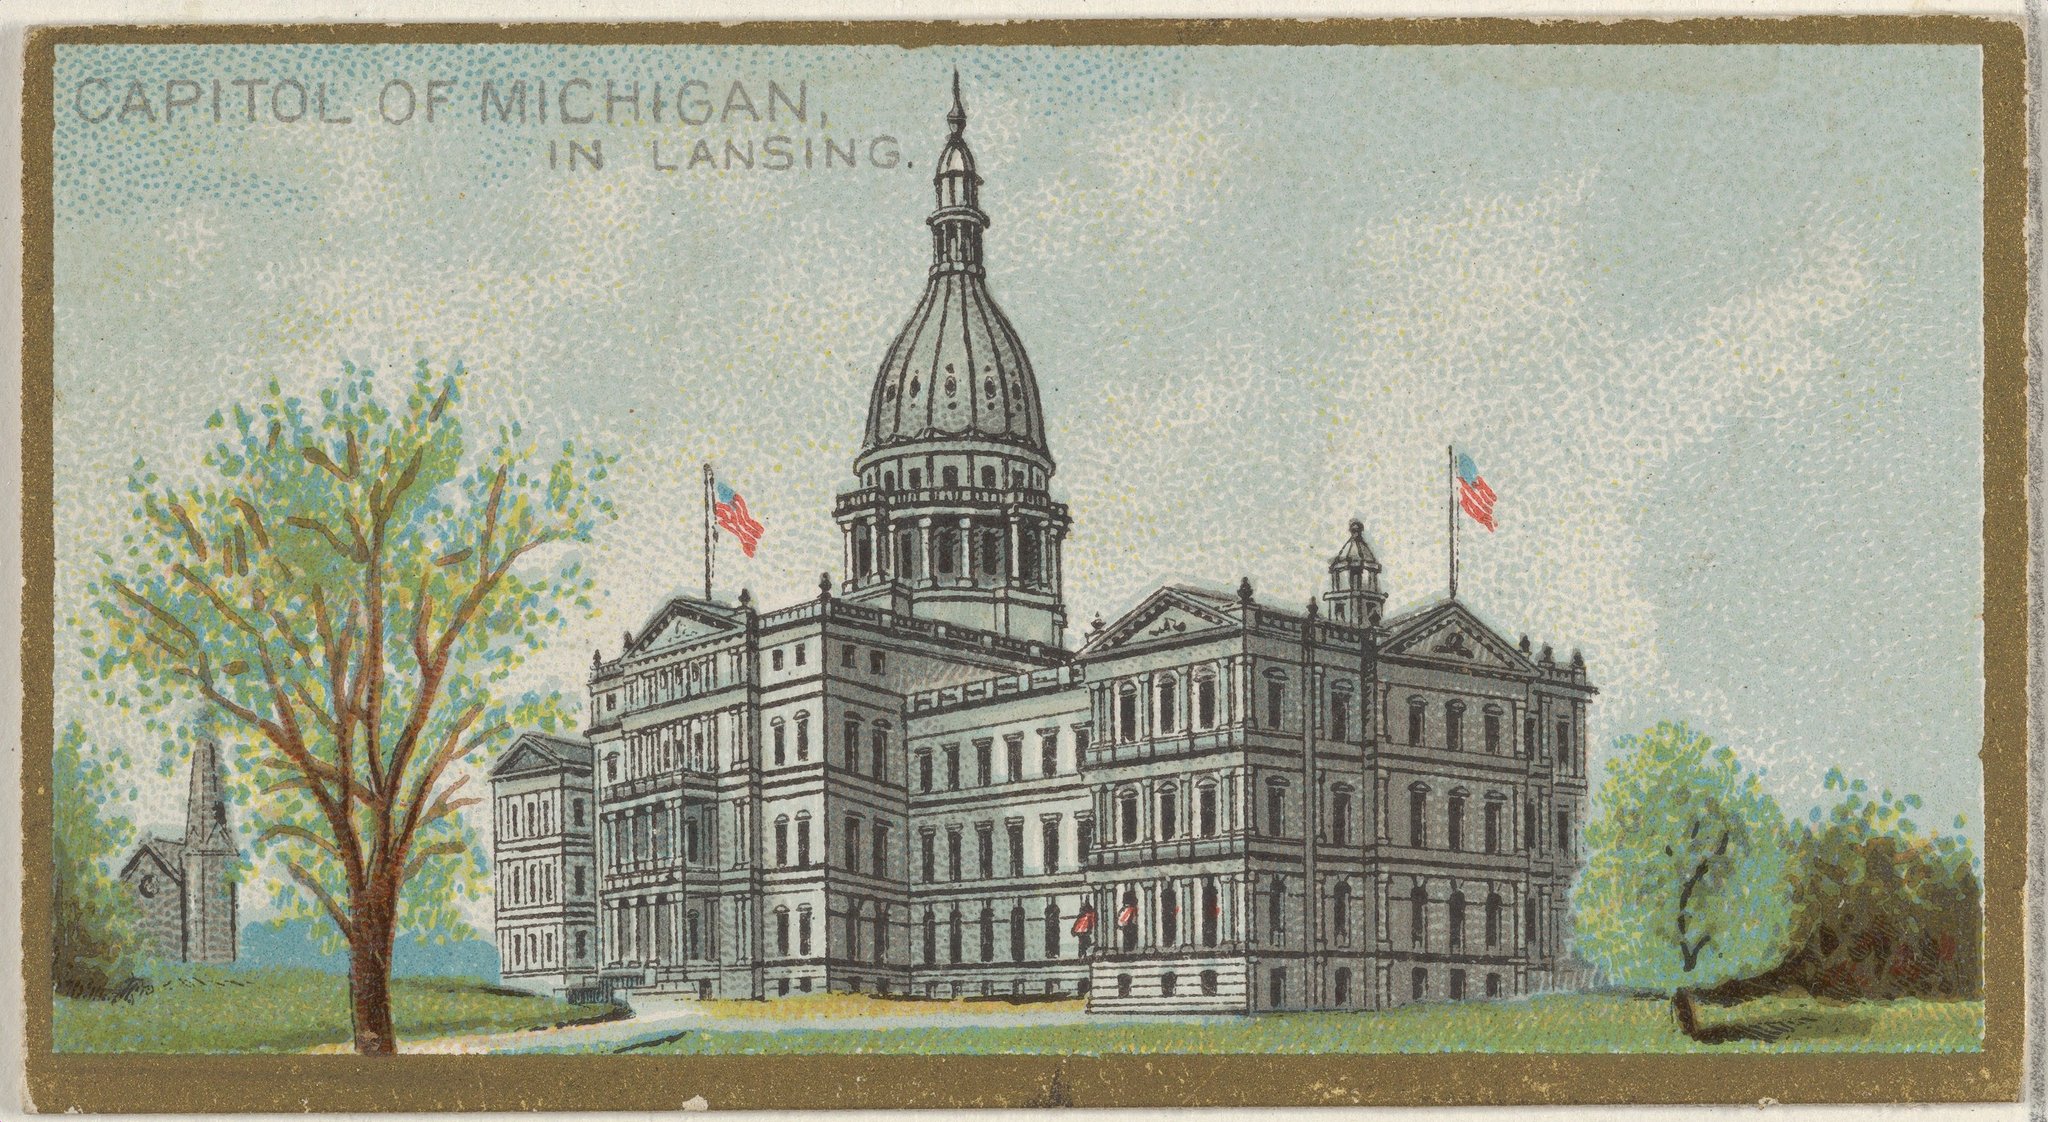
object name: print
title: Capitol of Michigan in Lansing, from the General Government and State Capitol Buildings series (N14) for Allen & Ginter Cigarettes Brands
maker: allen & ginter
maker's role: publisher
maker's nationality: american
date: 1889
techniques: color lithograph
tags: buildings